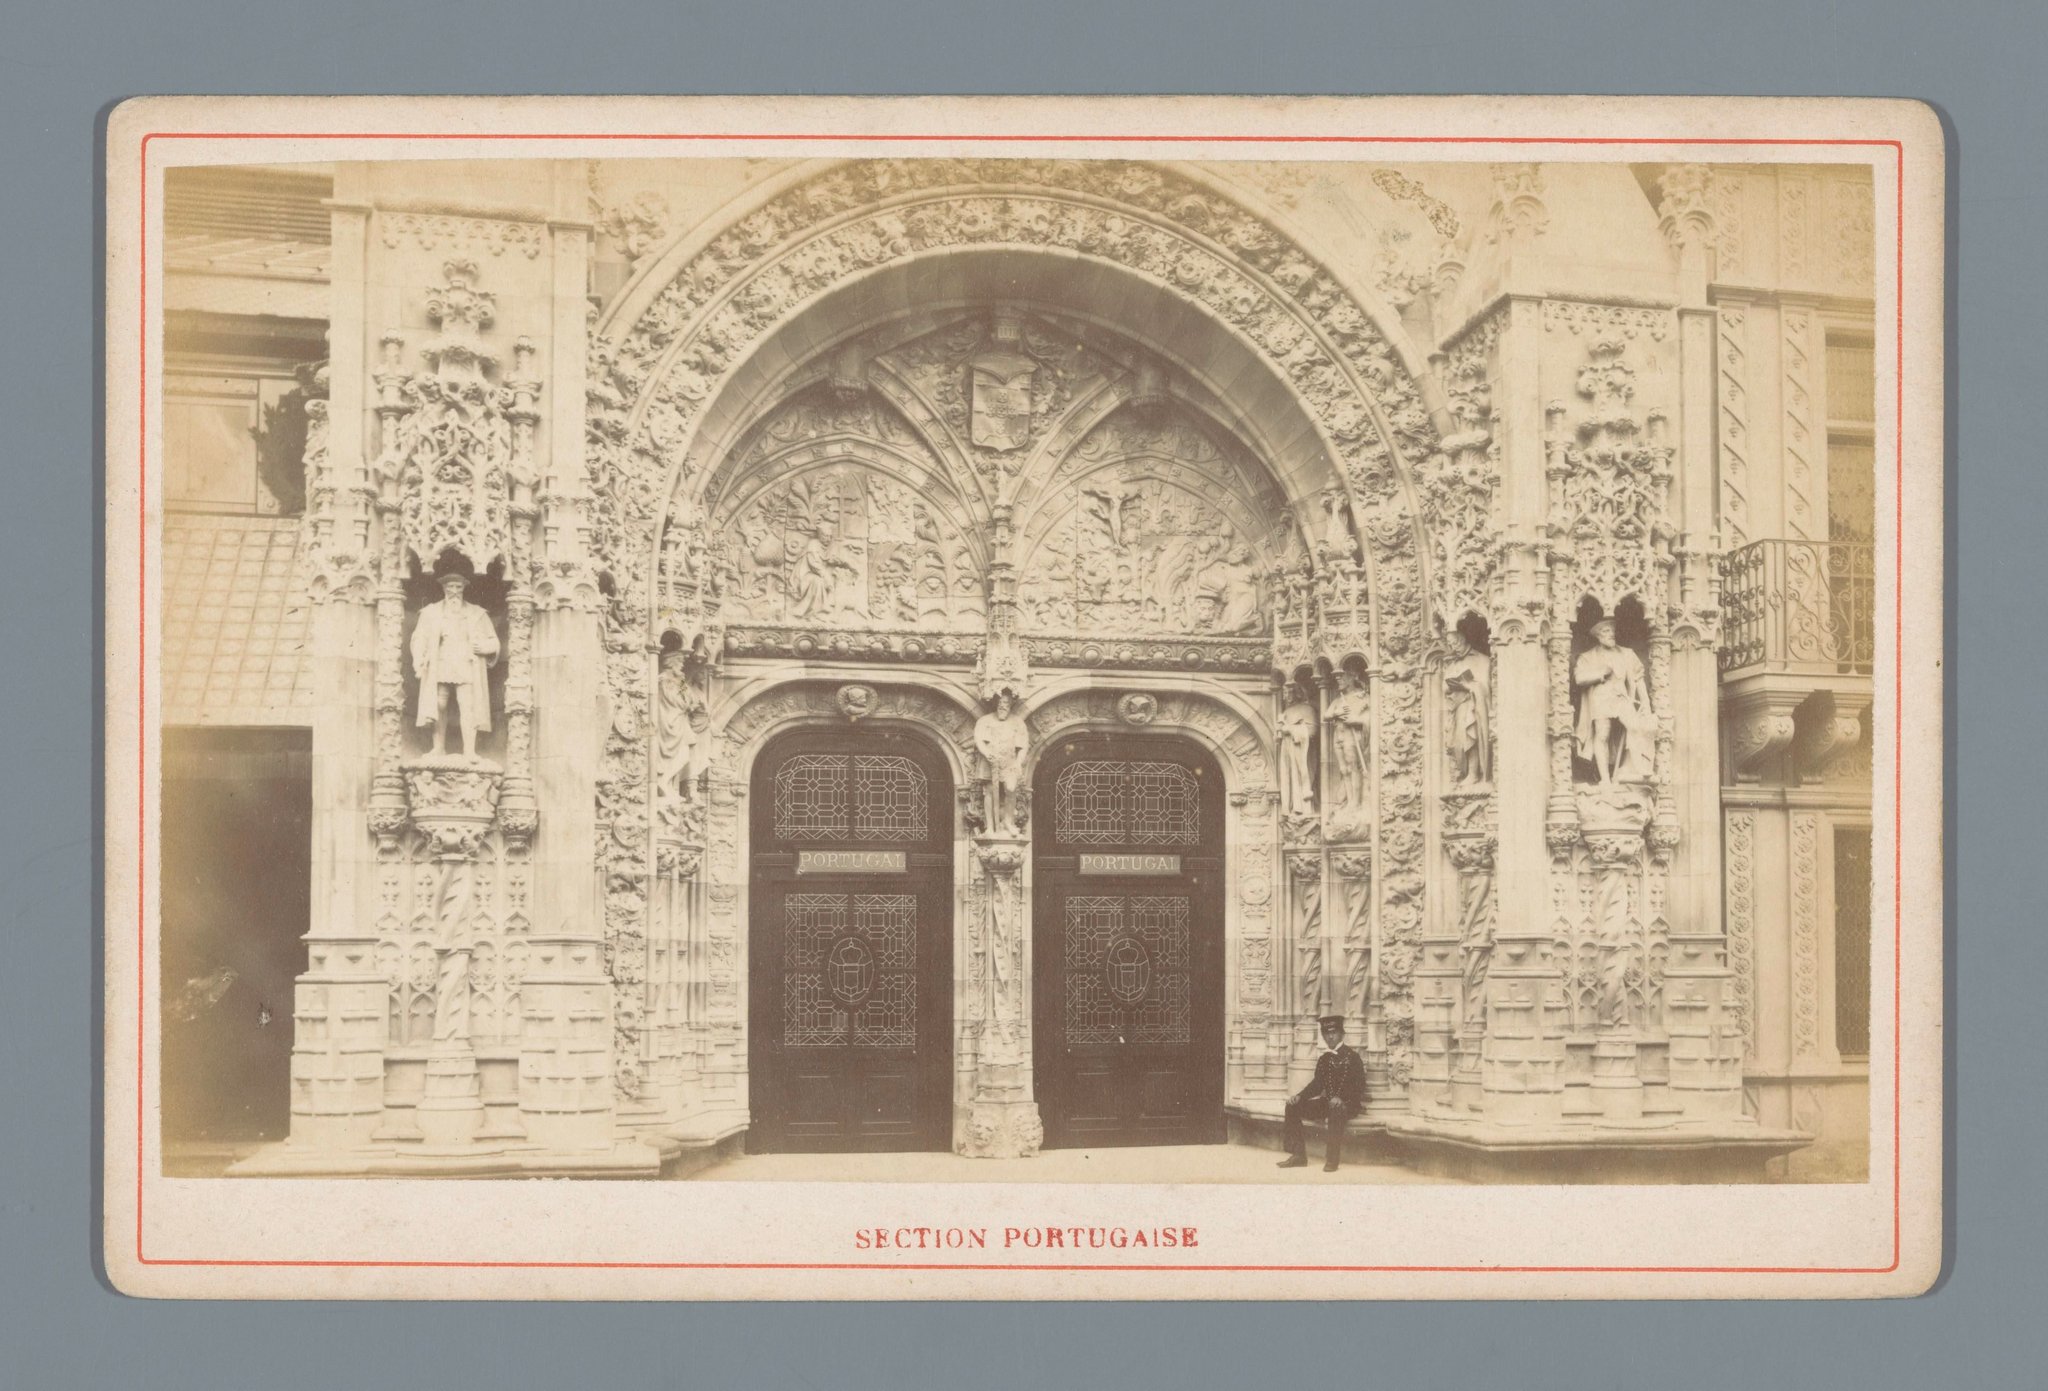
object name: photograph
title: Section Portugaise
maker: adolphe block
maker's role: publisher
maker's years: 1829-1918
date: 1878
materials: cardboard, photographic support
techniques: albumen print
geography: paris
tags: sitting figure - aa - female human figure, world fair, world exhibition, parts of church exterior and annexes, paris